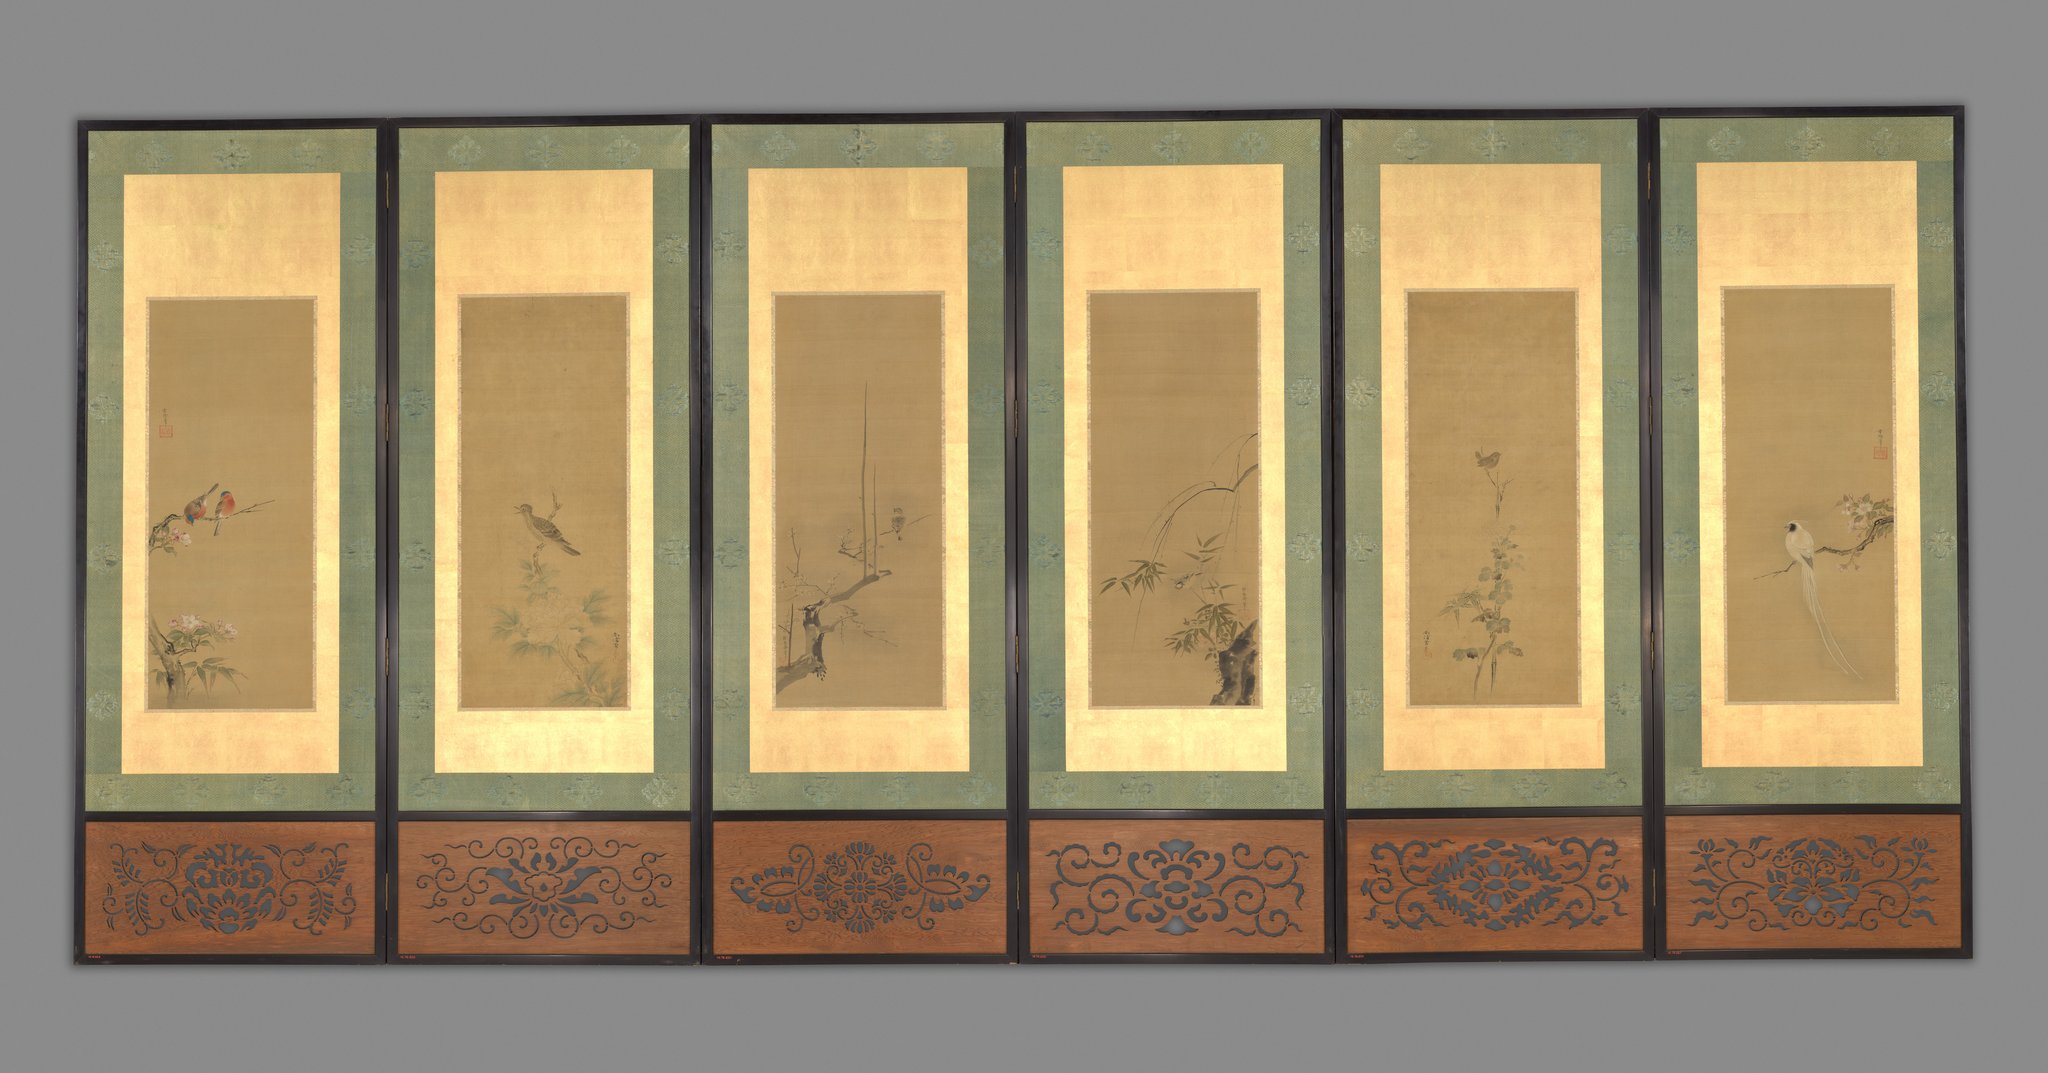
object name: screen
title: Birds and Flowers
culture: japanese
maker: kano tan'yū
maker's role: artist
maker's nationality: japanese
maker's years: 1602-1674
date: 1601-1700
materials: ink, panel, silk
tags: birds,flowers